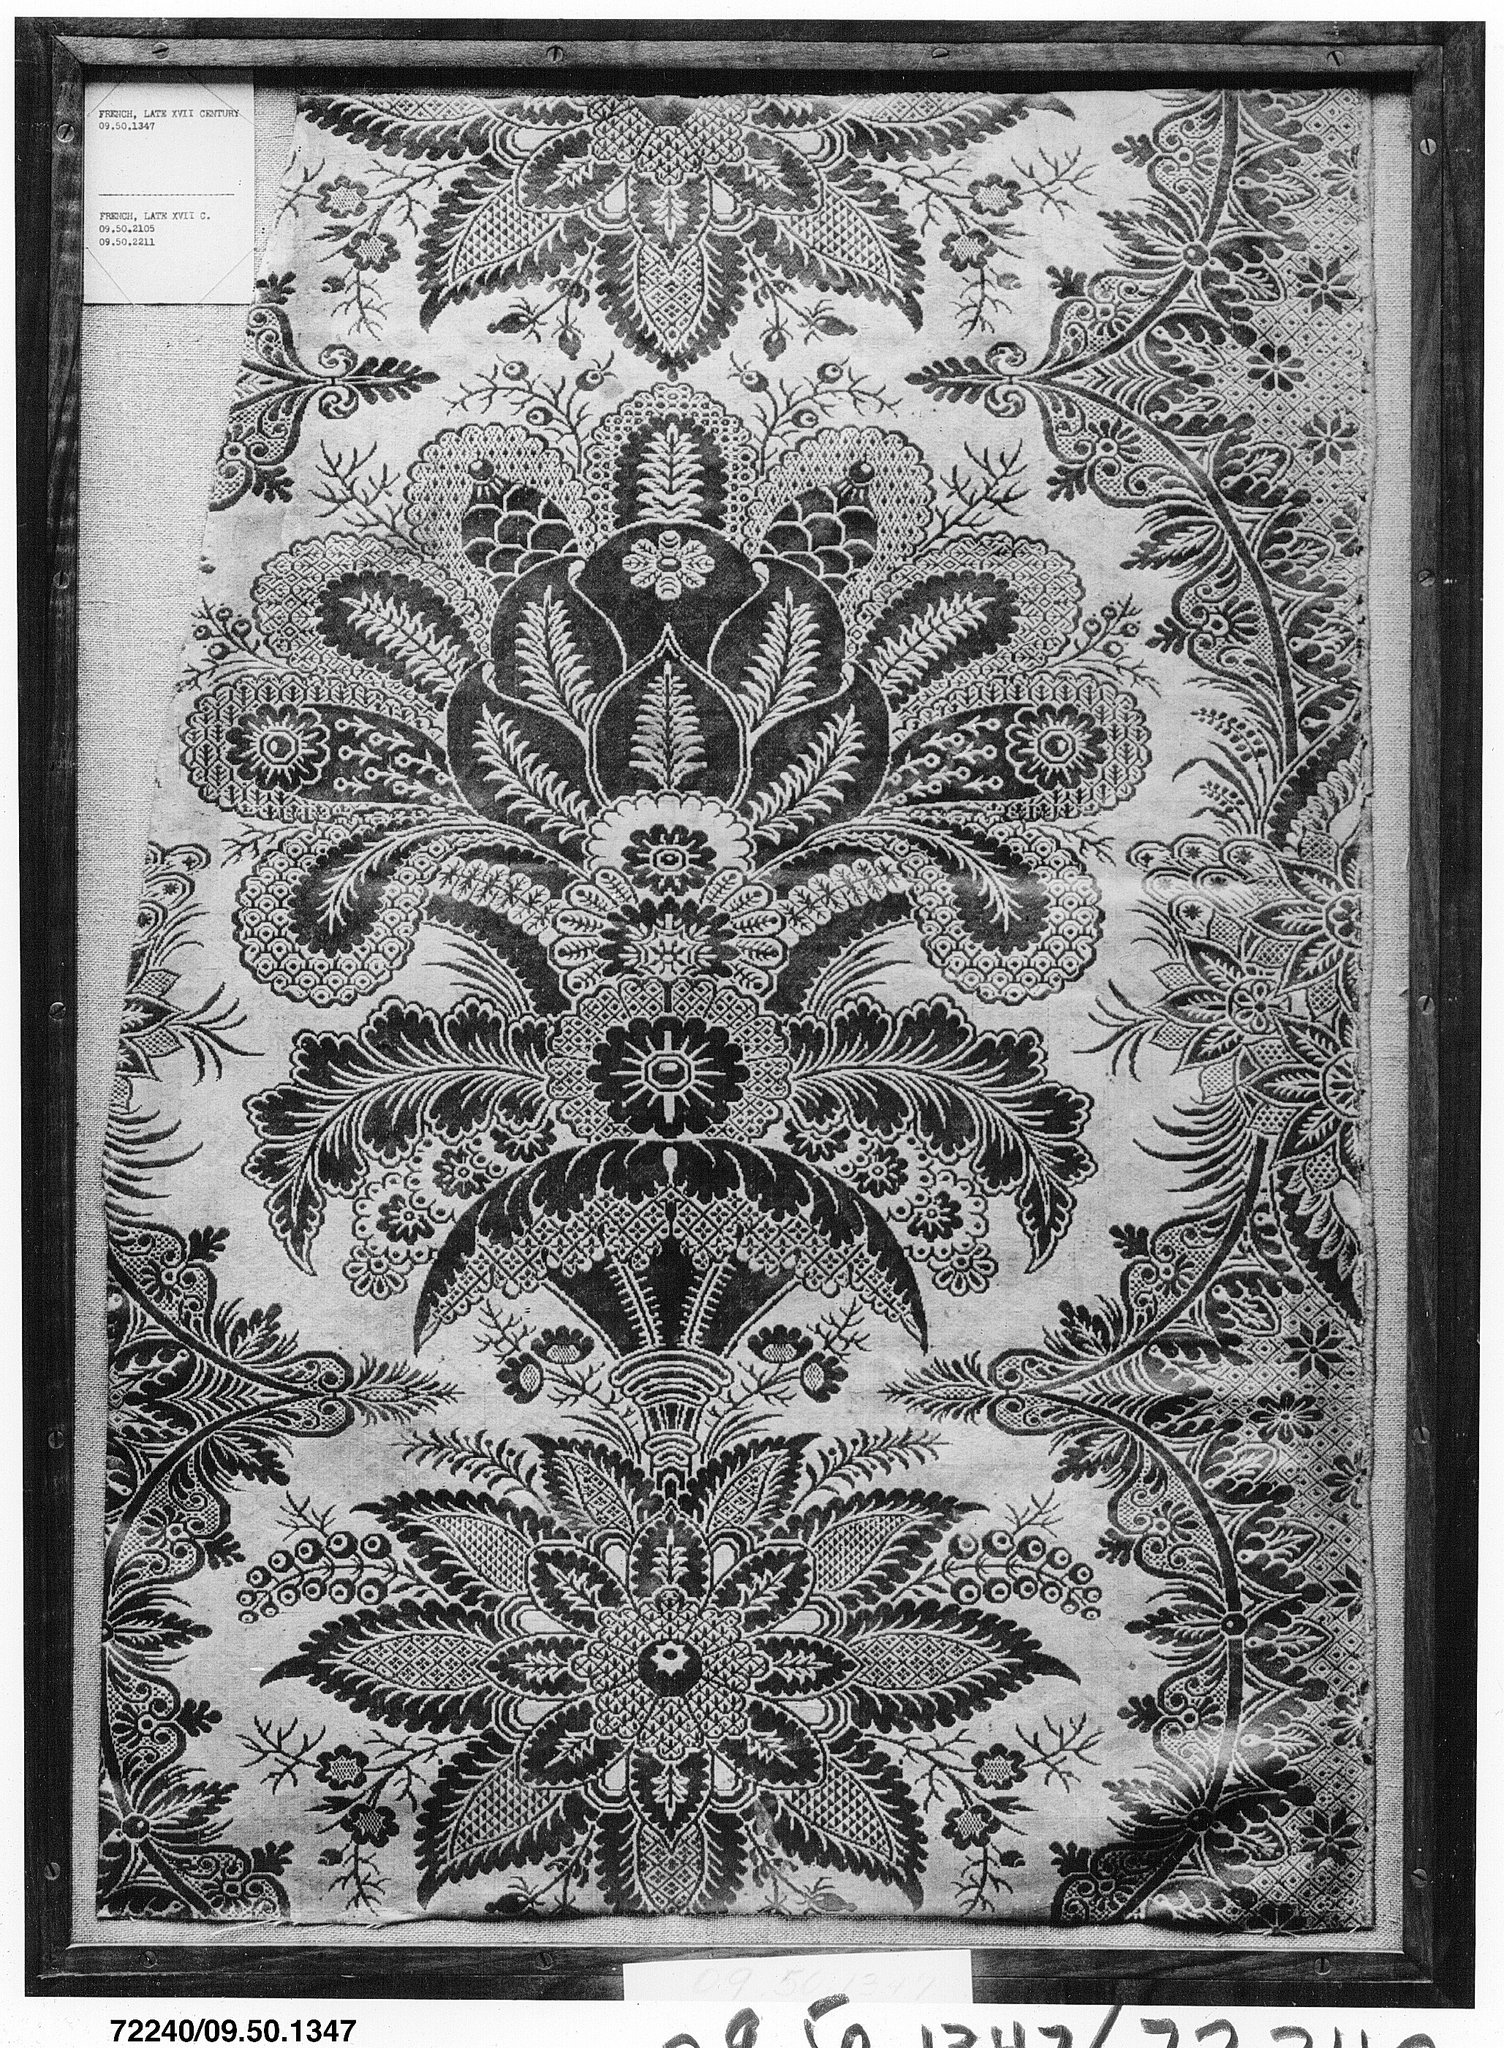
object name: piece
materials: silk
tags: flowers,leaves